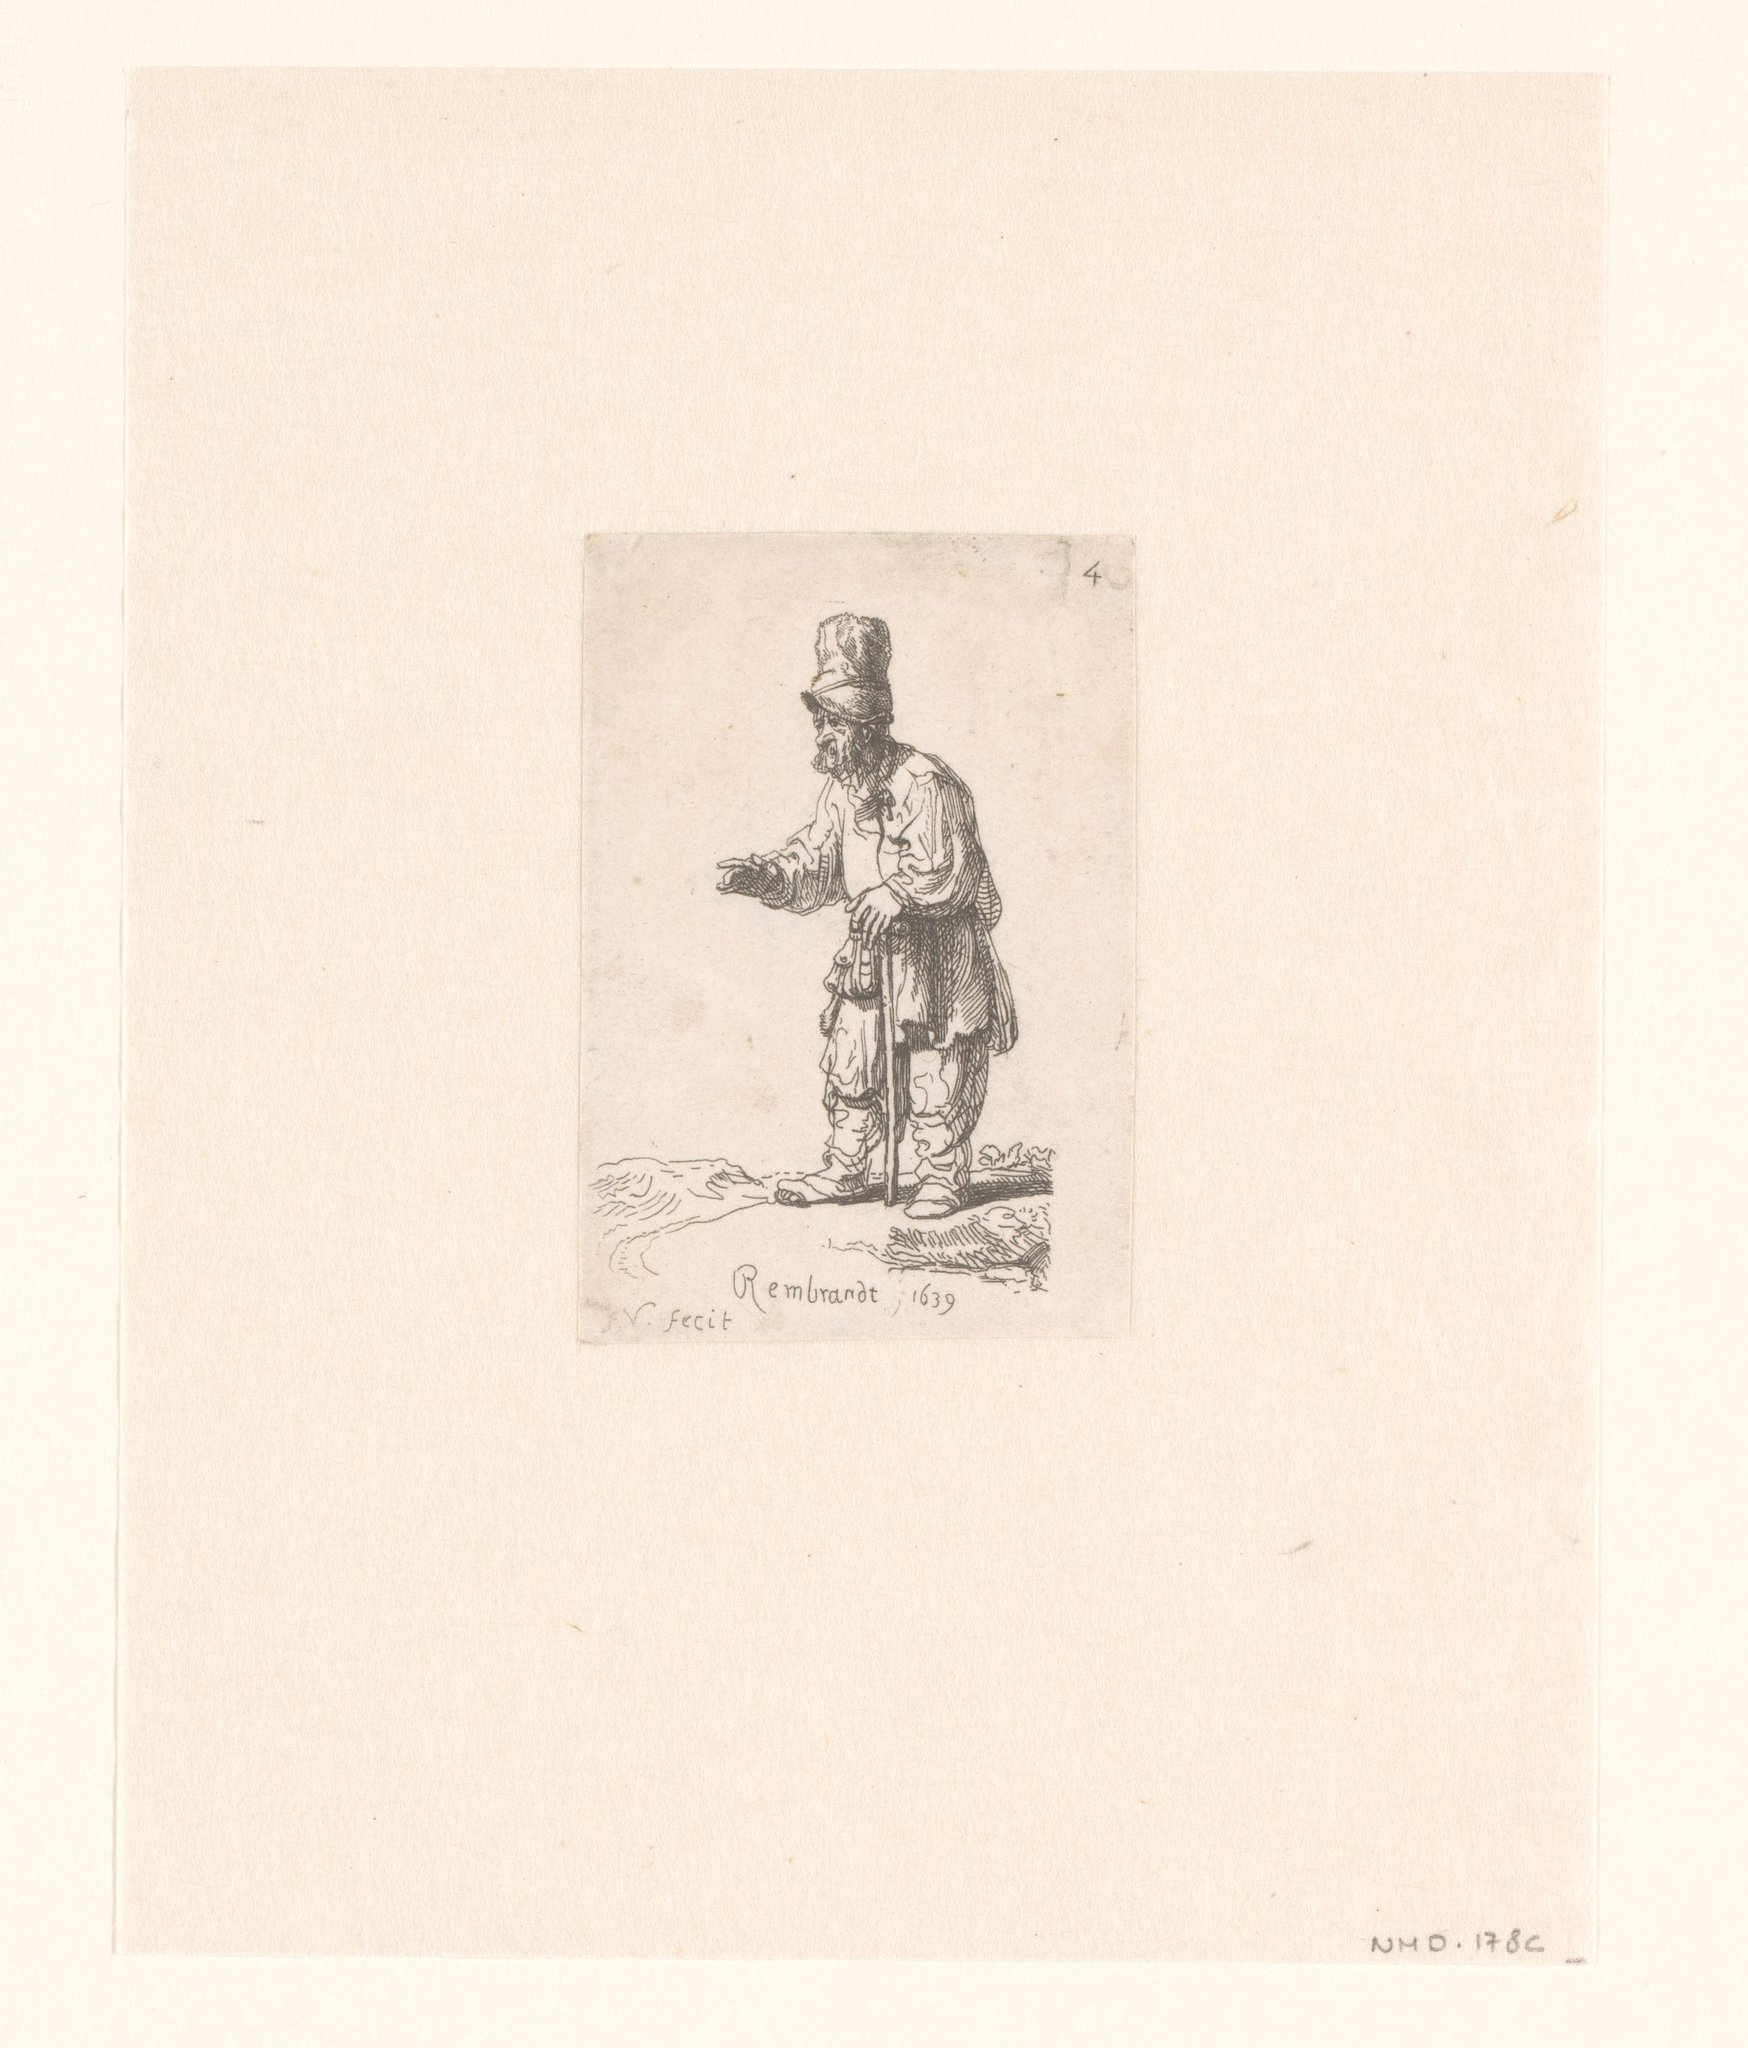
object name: print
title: A peasant in a high cap, standing leaning on a stick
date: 1719-1780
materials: paper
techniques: etching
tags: farmers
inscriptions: collector's mark: Lugt 2760, collector's mark: Lugt 2228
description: Spiegelbeeldige kopie naar de gelijknamige prent van Rembrandt. Prent gebruikt in: A collection of 200 original etchings. Londen: J.M. Creery, [1816].